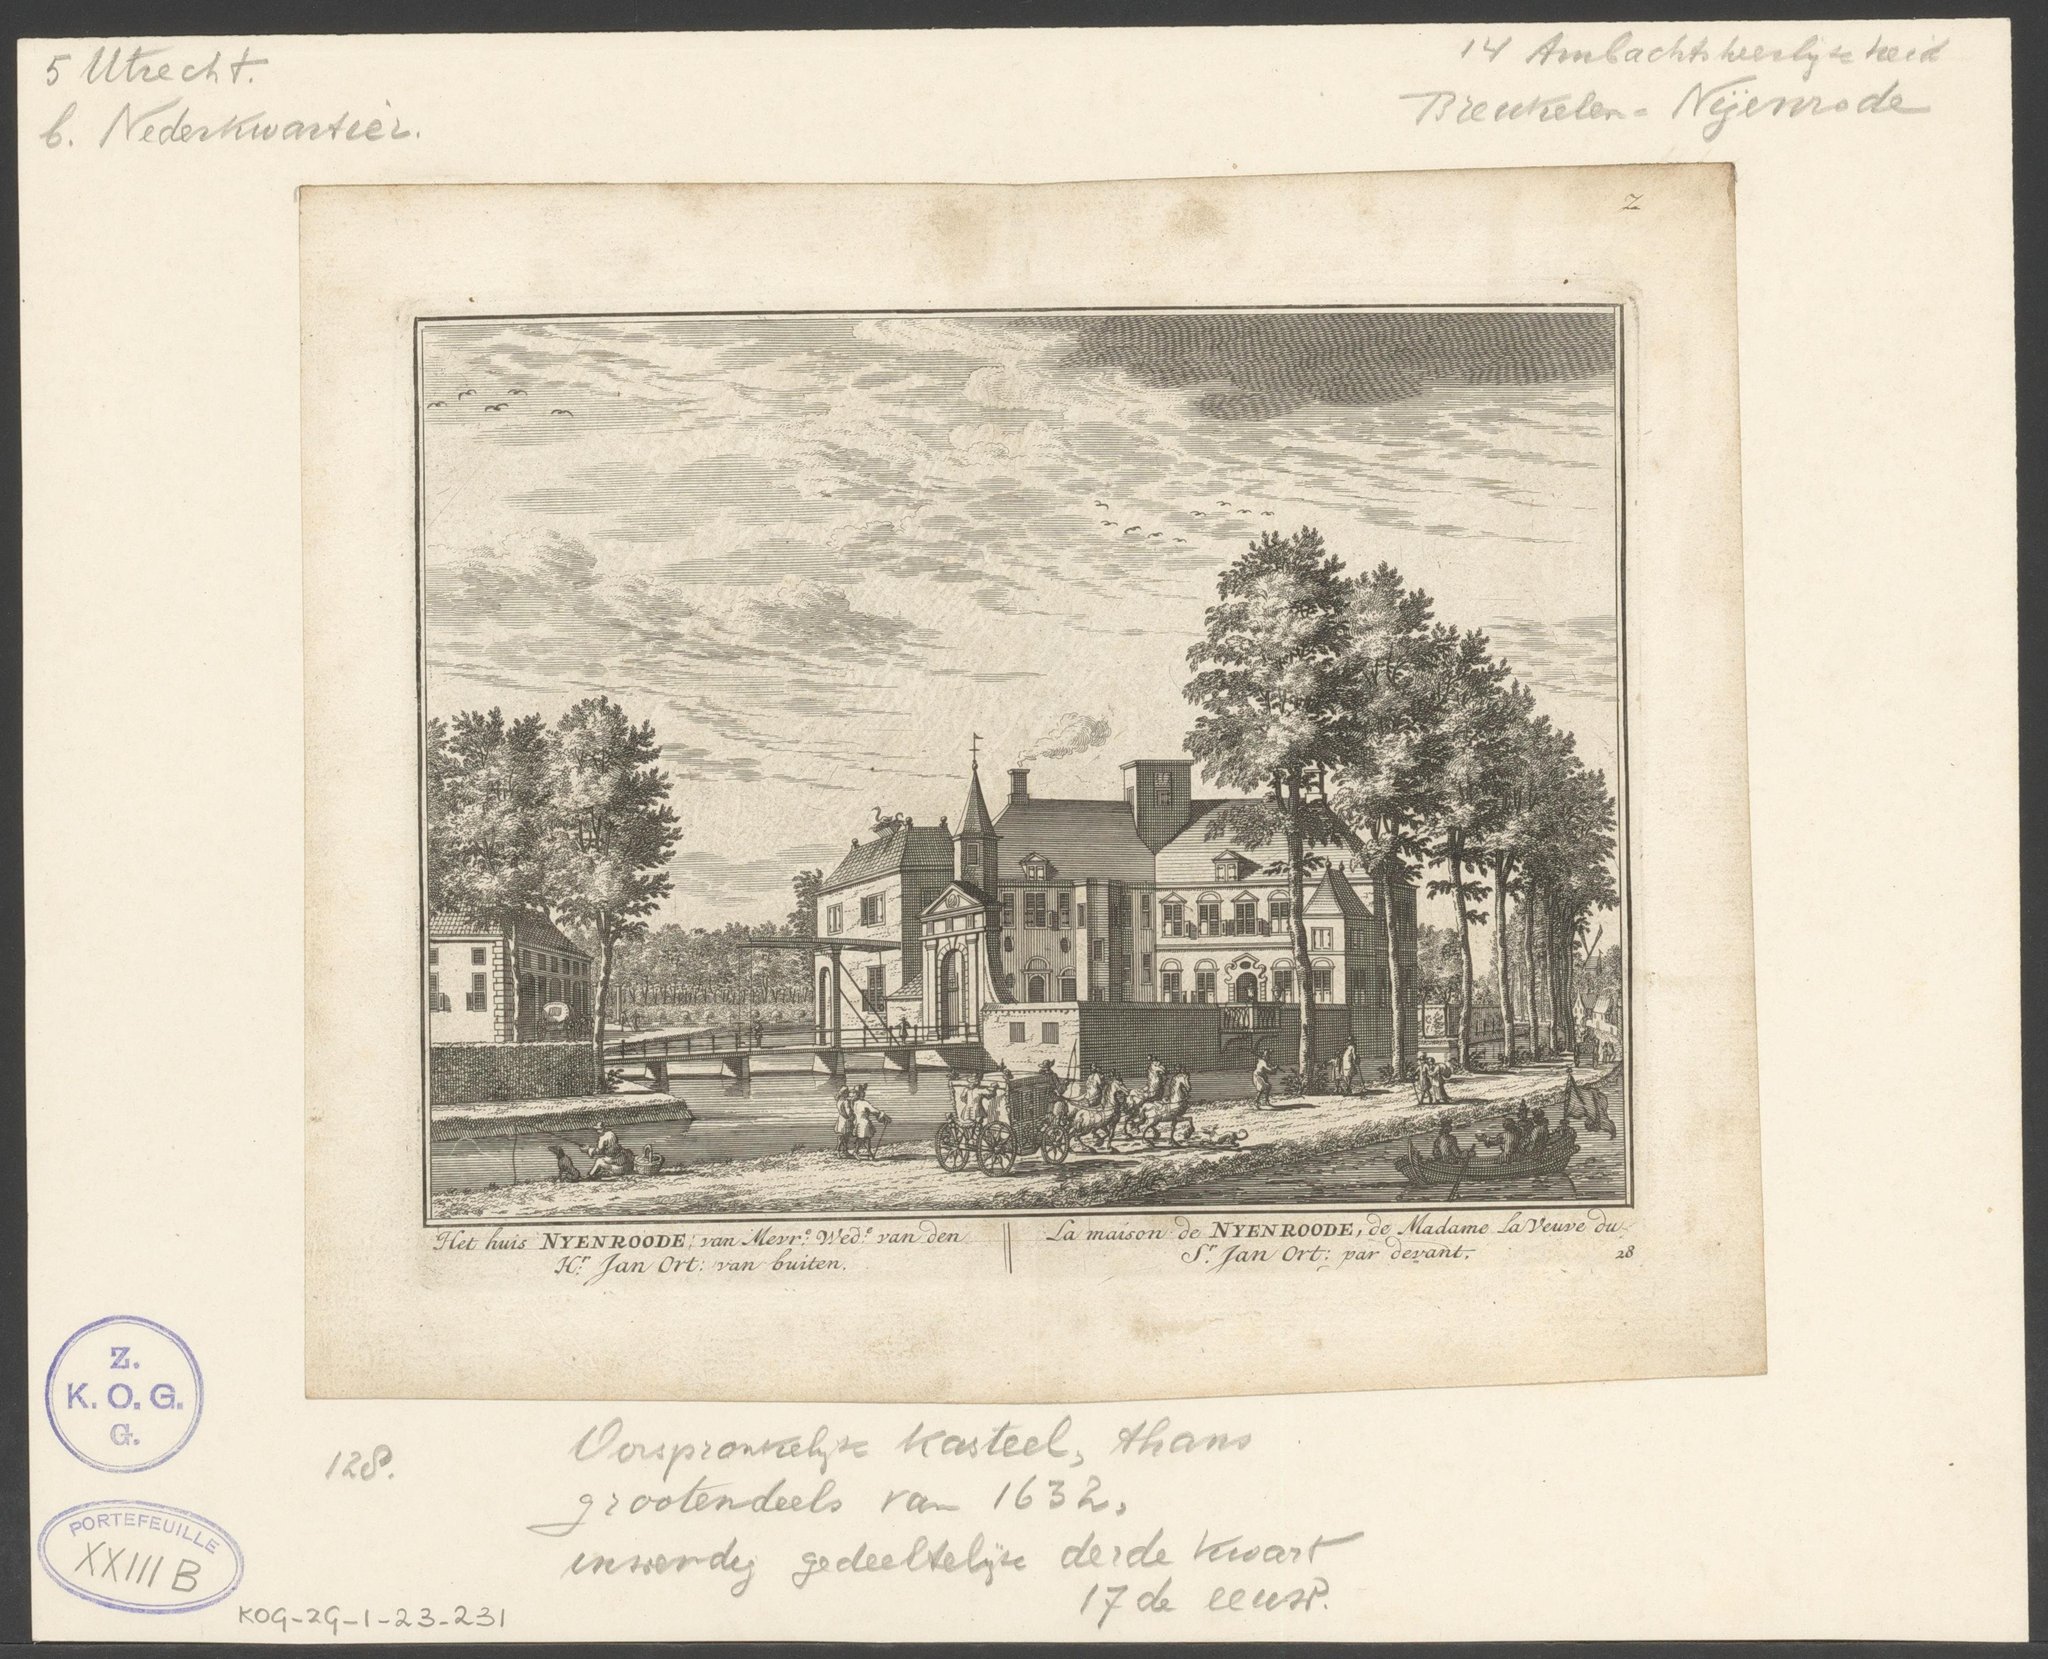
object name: print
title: Gezicht op het Kasteel Nijenrode bij Breukelen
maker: daniël stopendaal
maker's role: print maker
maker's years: 1672-1726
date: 1790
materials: paper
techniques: engraving, etching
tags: bridge, country-house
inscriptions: stamp, collector's mark: Lugt 1641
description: Rechtsonder genummerd: 25. Onderwerpsrubrieken binnen de Atlas Zeden en Gewoonten: Zeden en gewoonten in Engeren zin, De woning, Kastelen en buitenplaatsen.